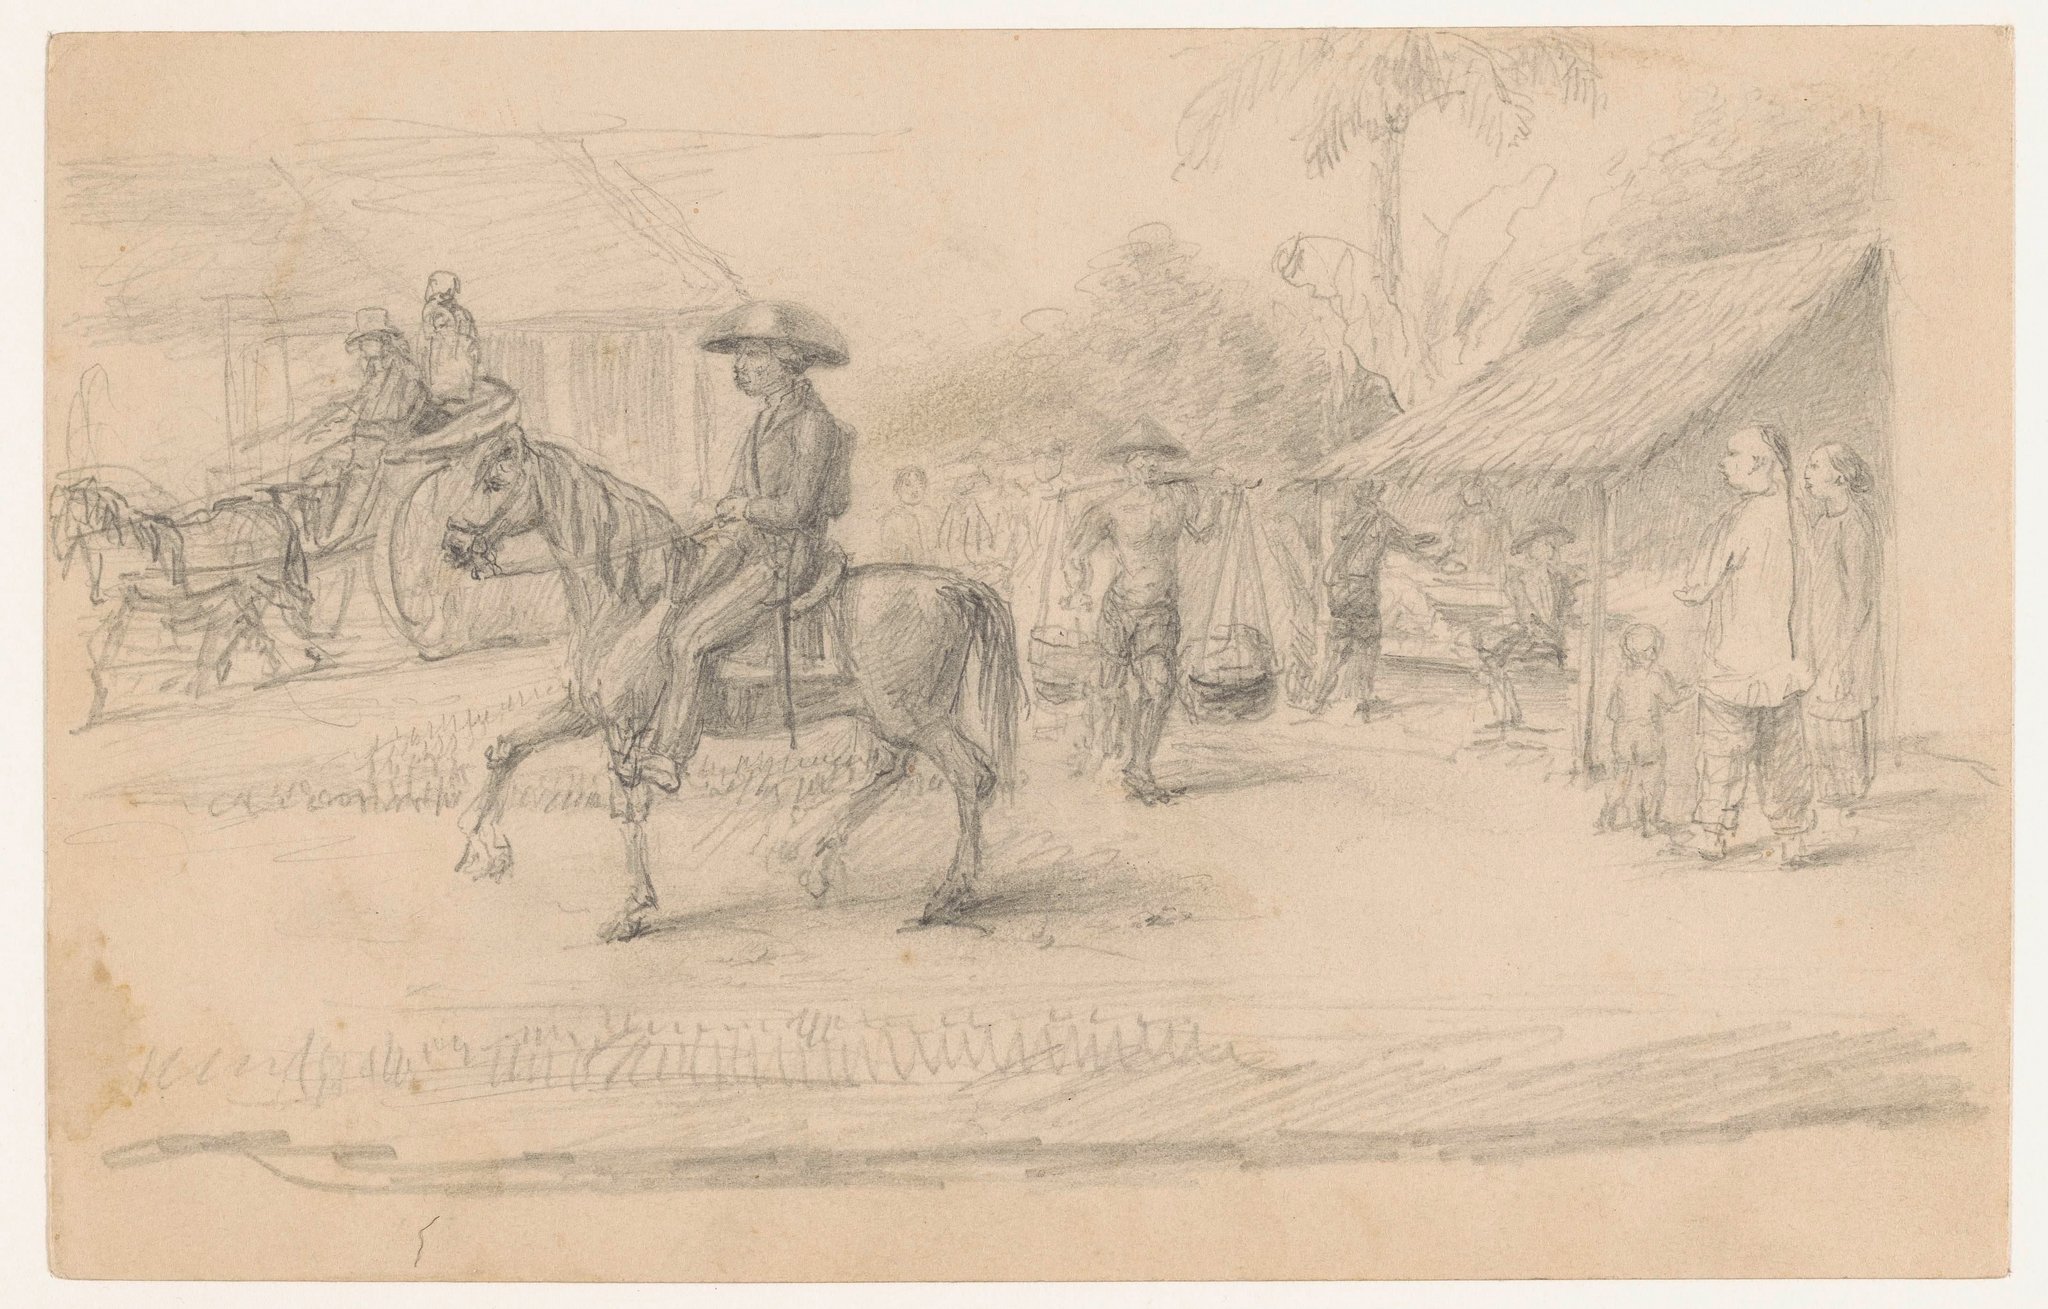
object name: drawing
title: Dorpsbeeld in N.O. Indië met op de voorgrond een ruiter te paard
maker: christian heinrich gottlieb steuerwald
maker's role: draughtsman, print maker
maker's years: 1802-1874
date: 1848-1854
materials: paper, pencil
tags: village street